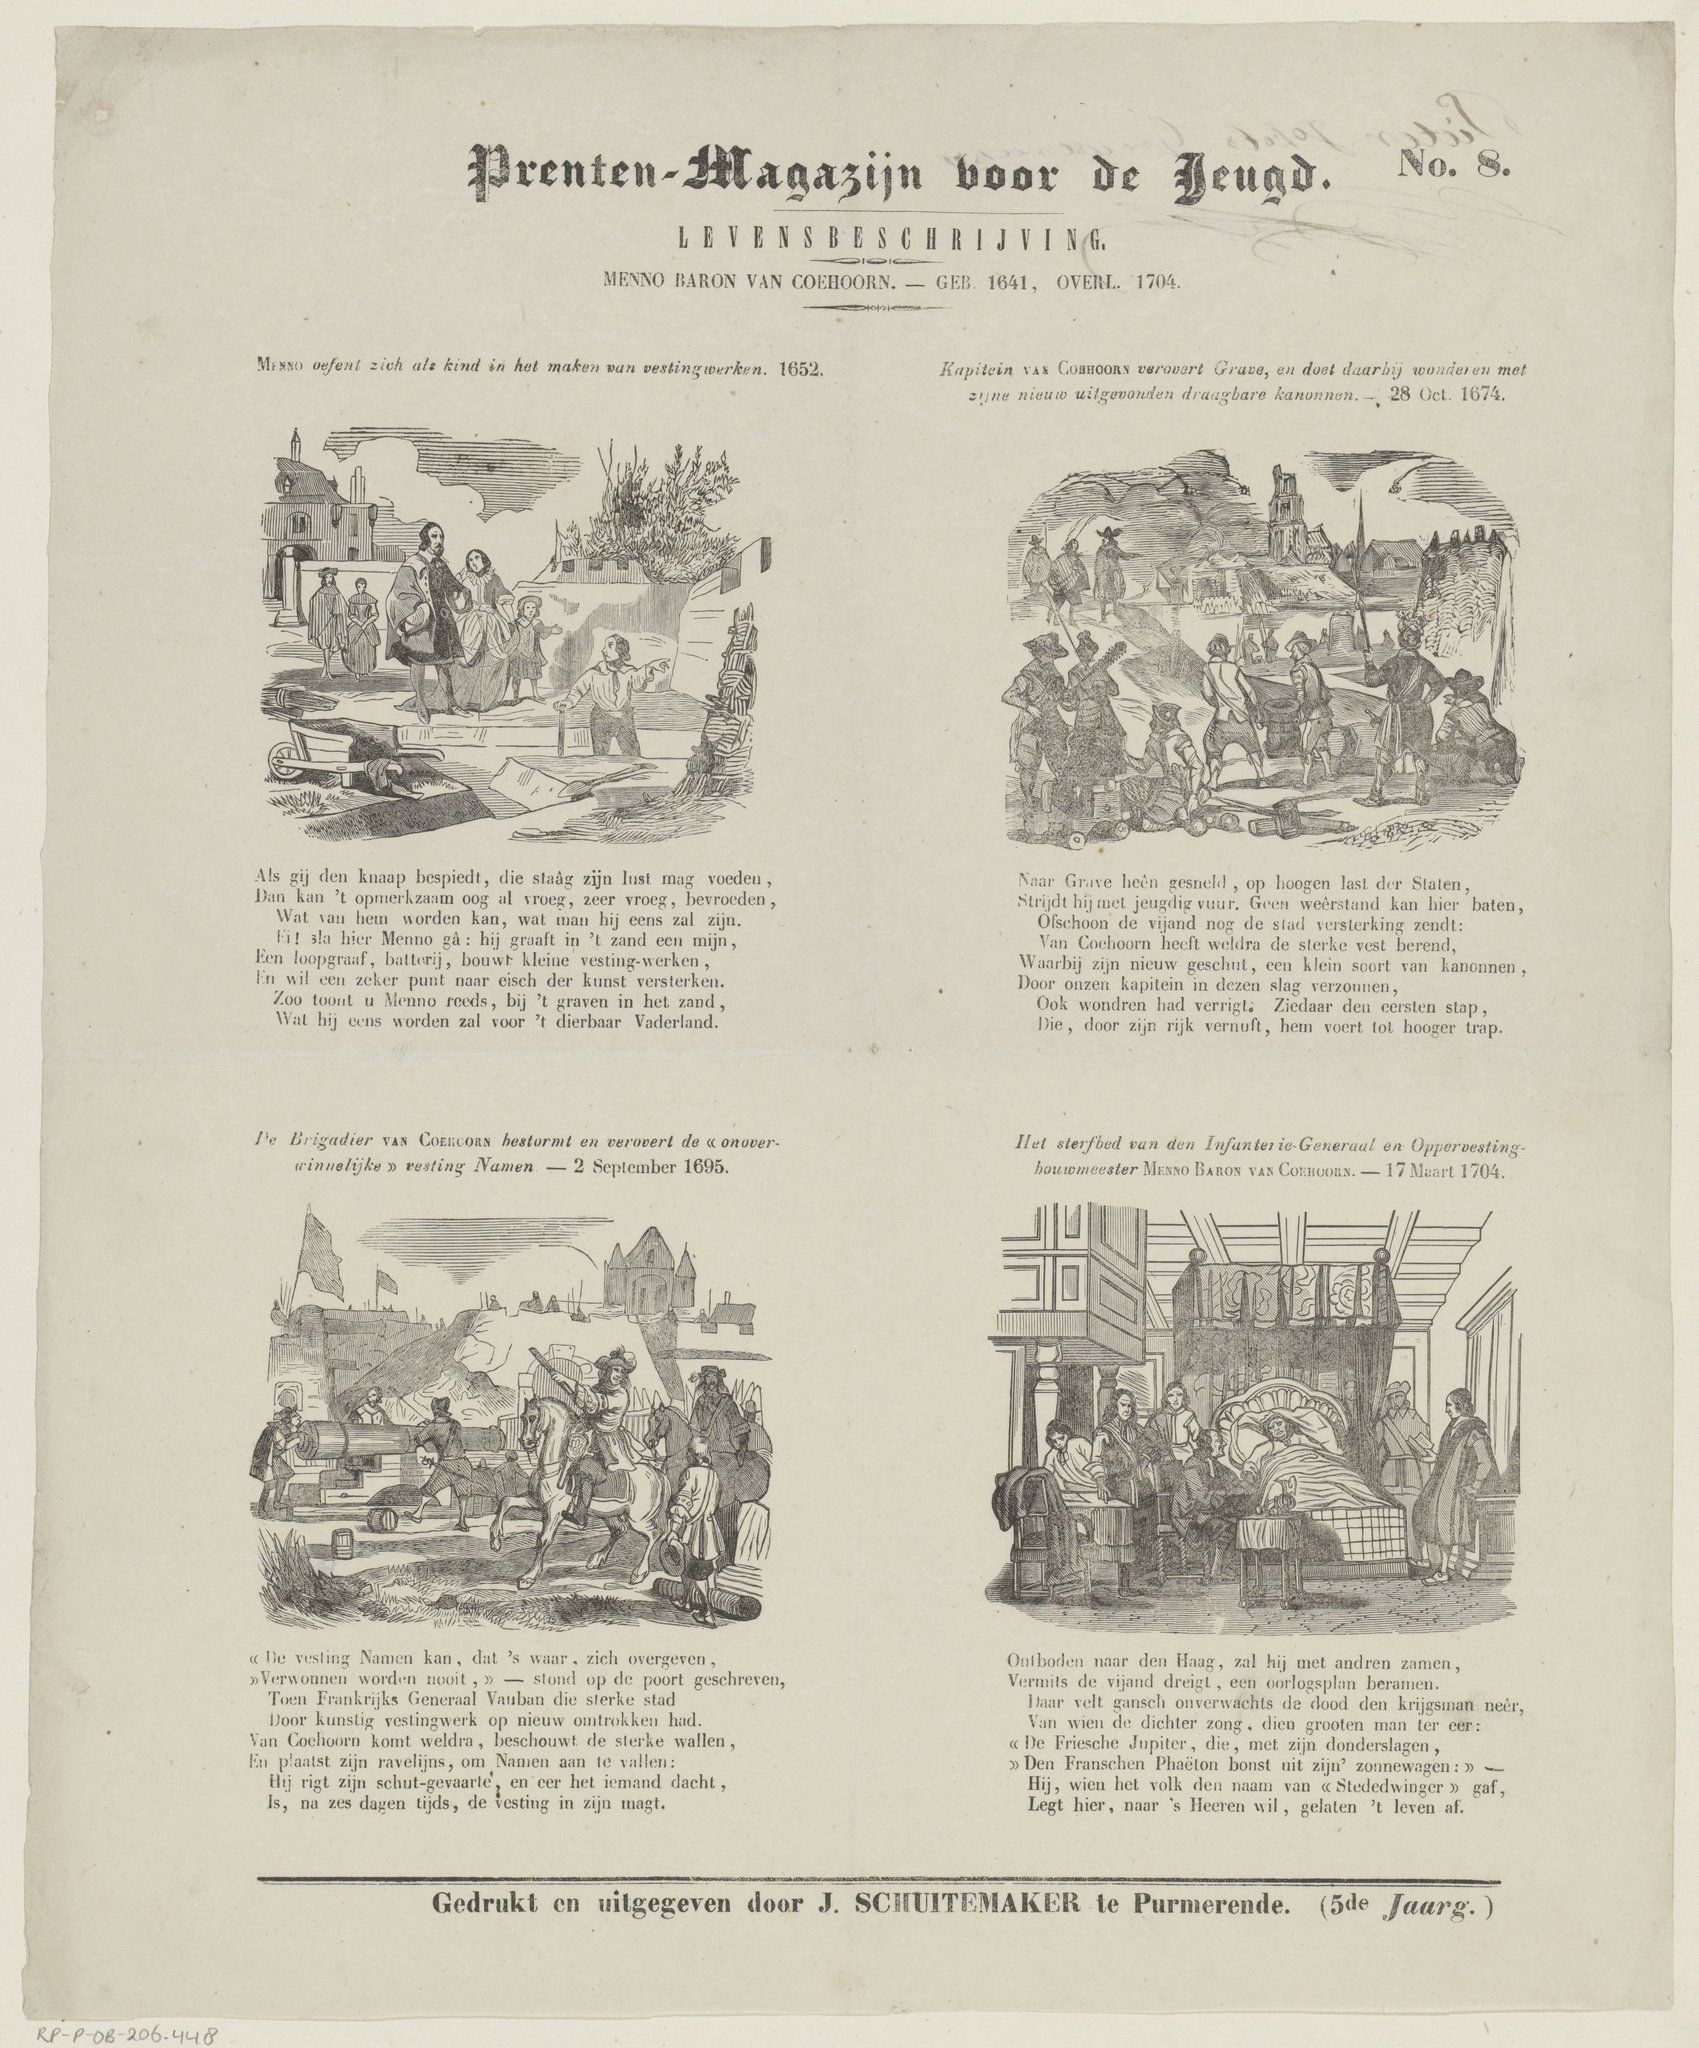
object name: print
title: Levensbeschrijving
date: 1846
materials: paper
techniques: letterpress printing, engraving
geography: purmerend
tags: the hague, grave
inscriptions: inscription, collector's mark: Lugt 2760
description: Blad met 4 voorstellingen uit het leven van Menno, baron van Coehoorn. Boven elke voorstelling een titel en onder elke voorstelling een achtregelig vers. Genummerd rechtsboven: No. 8.